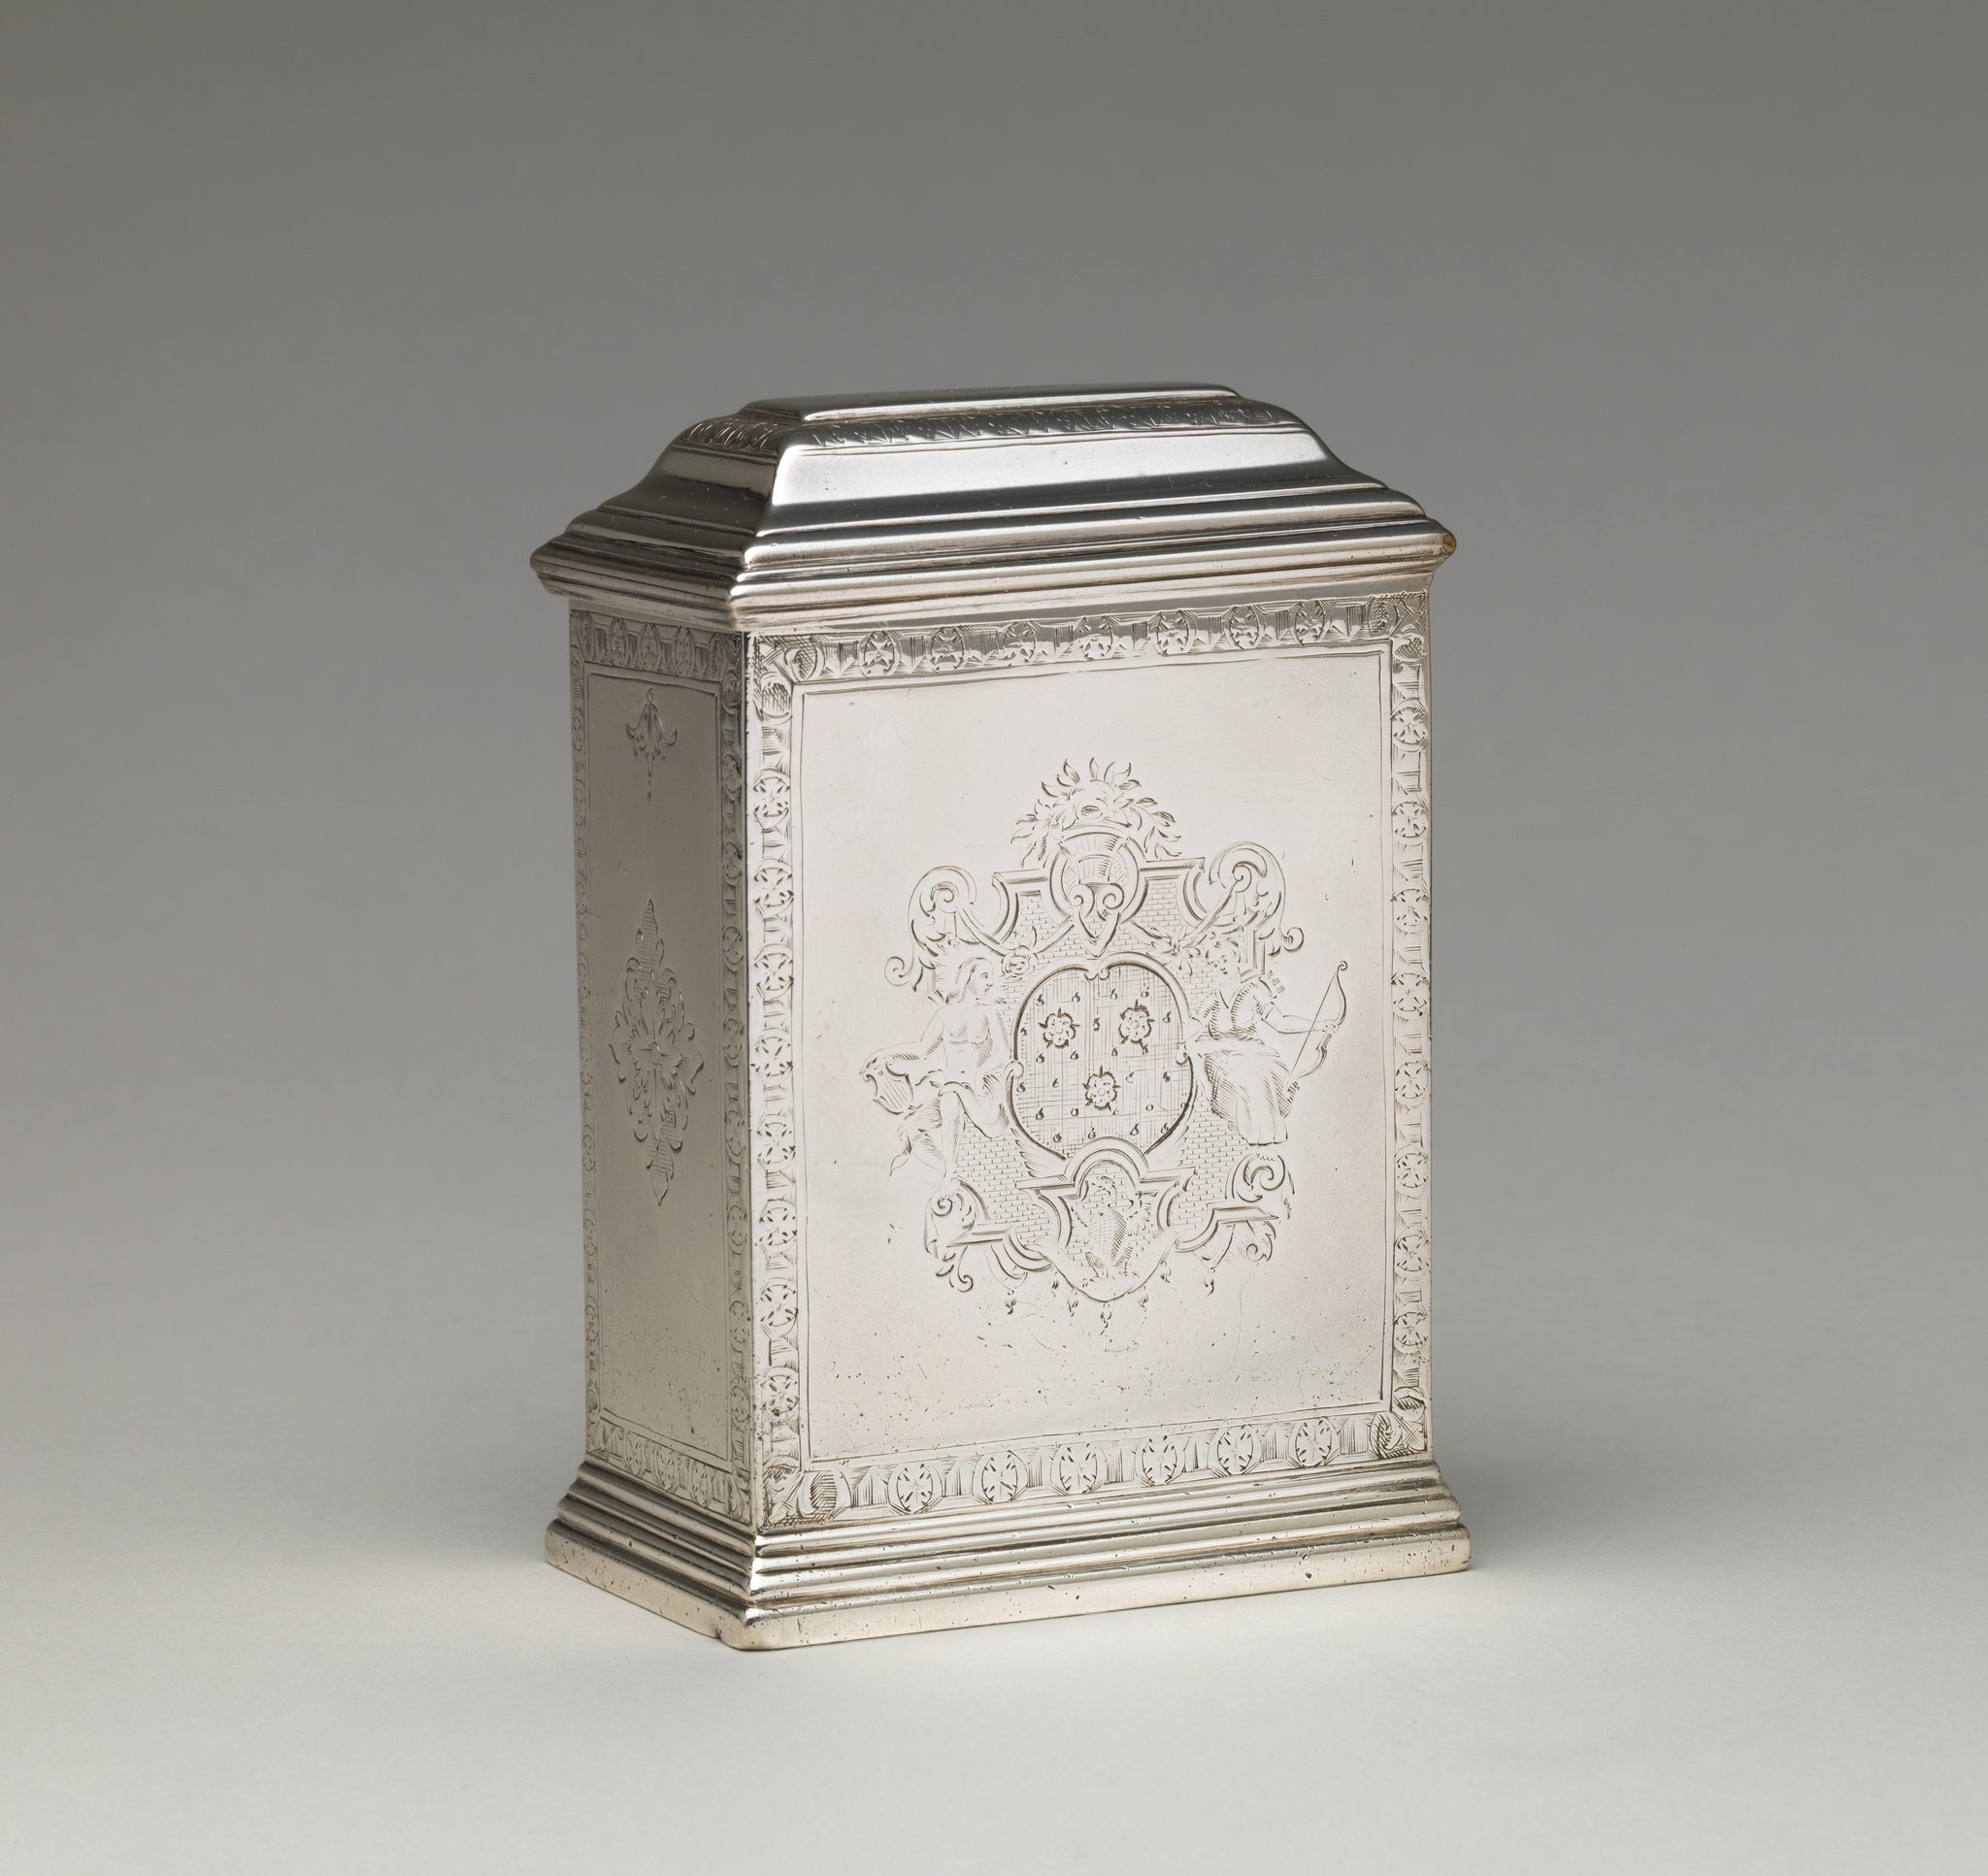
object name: tea caddy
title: Tea caddy (one of a pair)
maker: augustin courtauld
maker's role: maker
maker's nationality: british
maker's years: 1685-1751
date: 1726-1727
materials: silver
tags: coat of arms